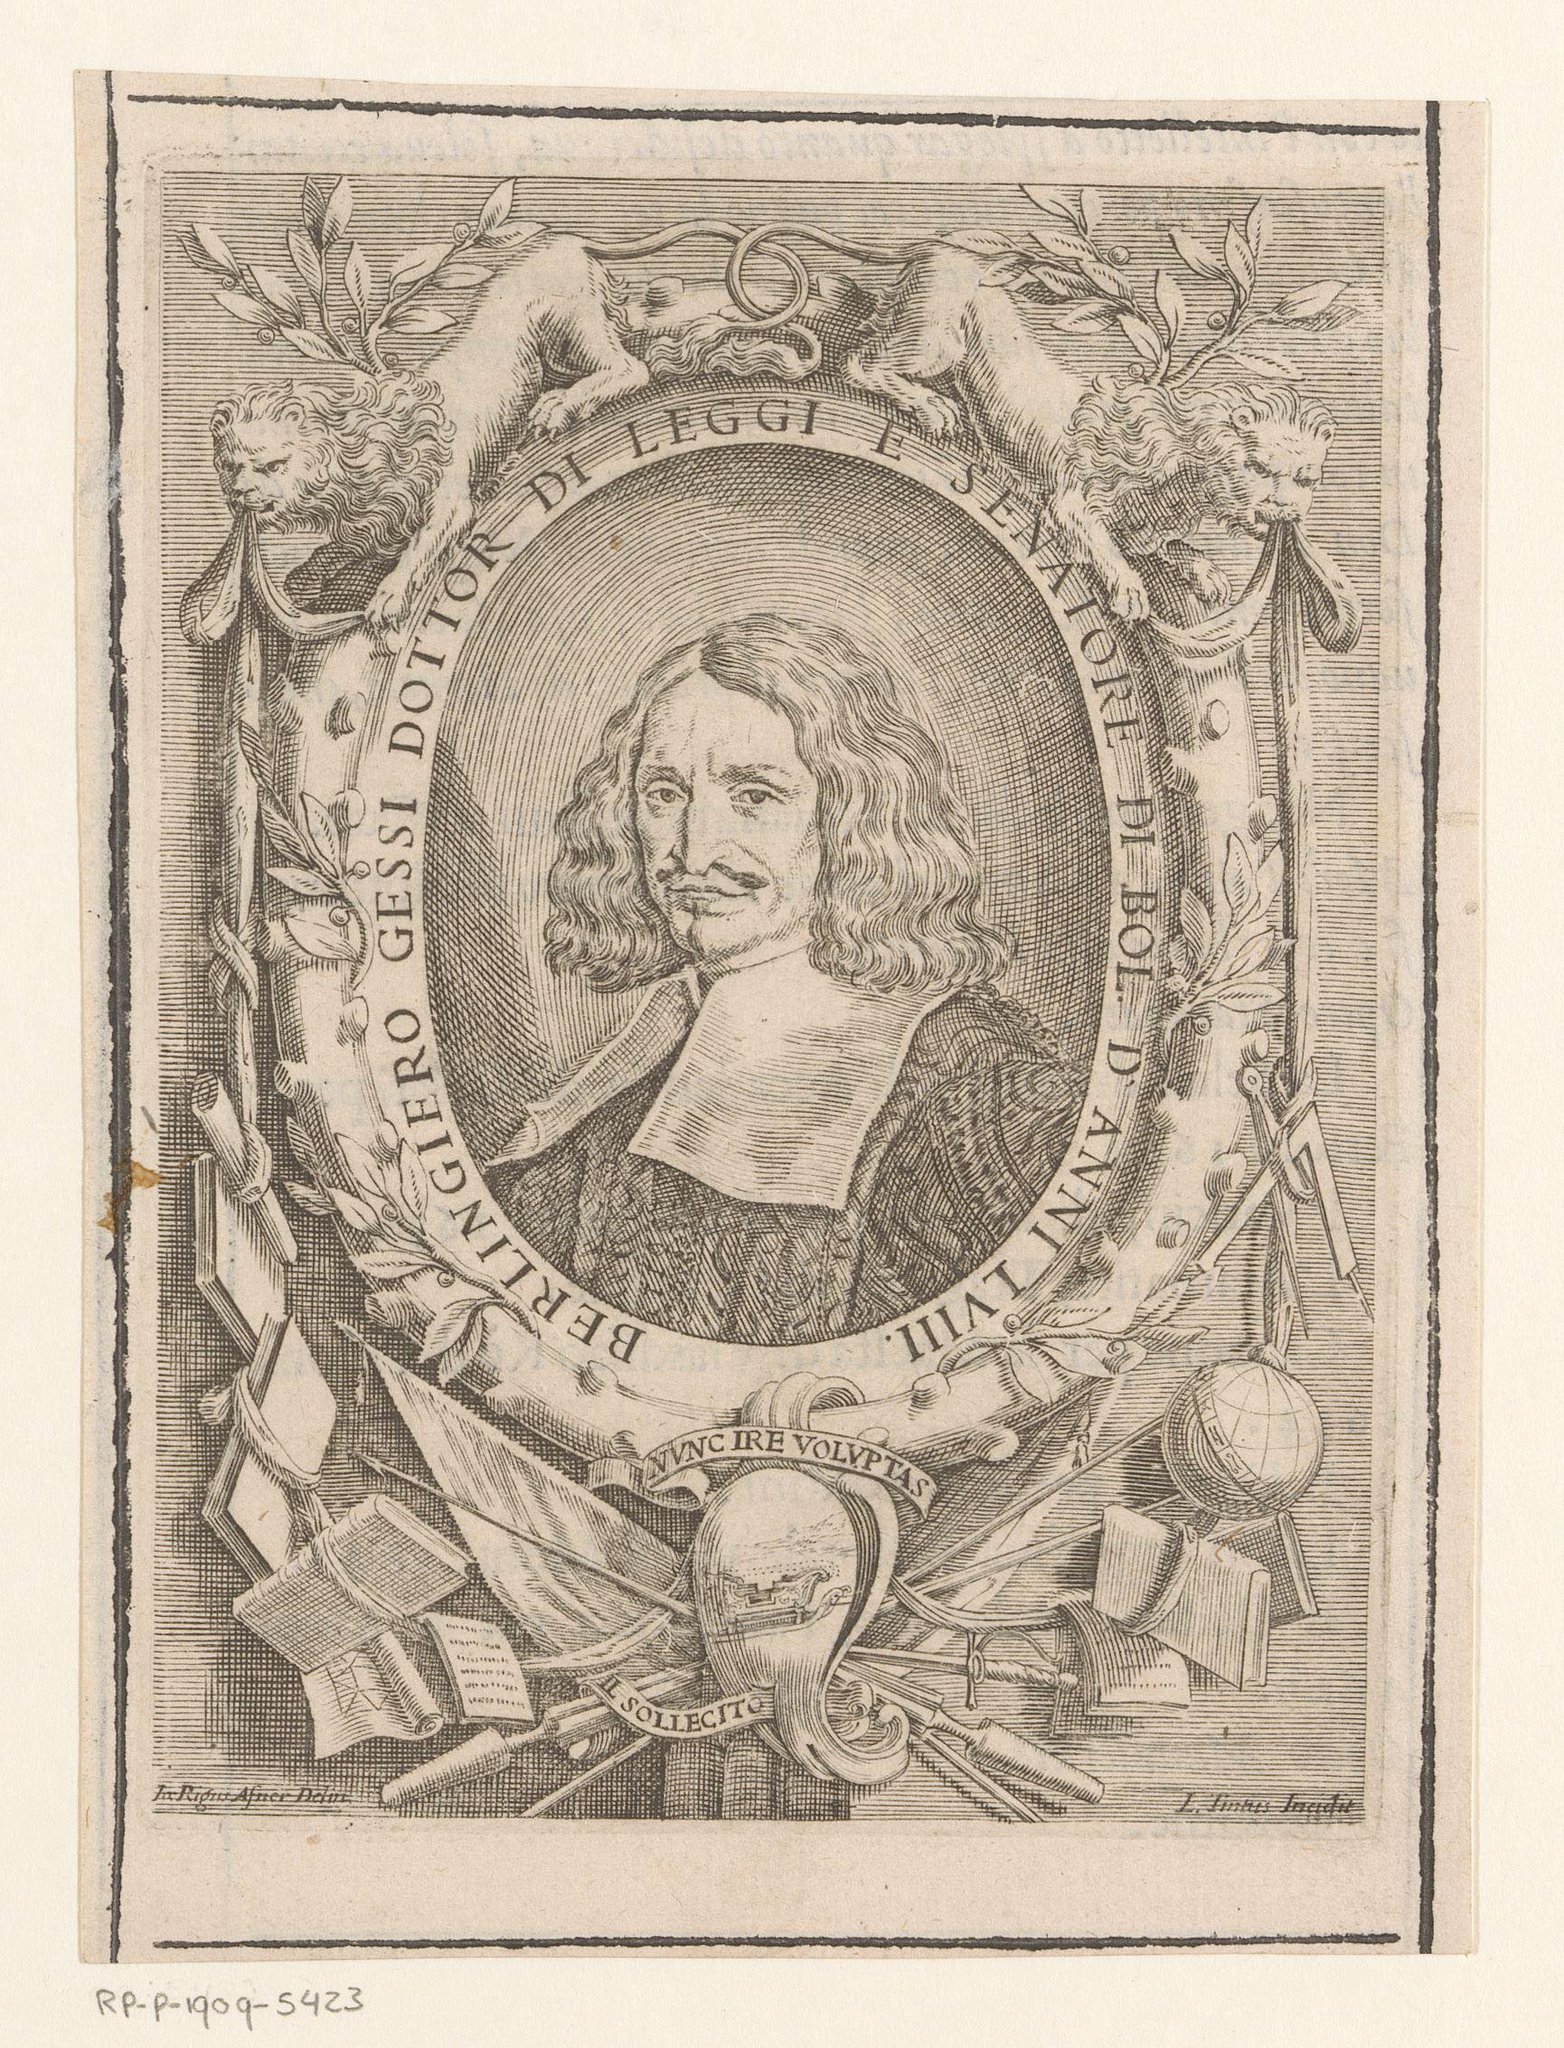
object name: print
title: Portret van kardinaal Berlinghiero Gessi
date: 1636-1672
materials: paper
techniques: engraving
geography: italy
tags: rome, cardinal, historical persons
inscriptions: collector's mark: Lugt 2228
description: Prent gebruikt voor de publicatie: Gessi, Berlinghiero. La spada di honore. Bologna, 1671. Eveneens gebruikt voor de publicatie: Zani, Valerio. Memorie imprese, e ritratti de' Signori Accademici Gelati di Bologna. Bologna: s.n., 1672.